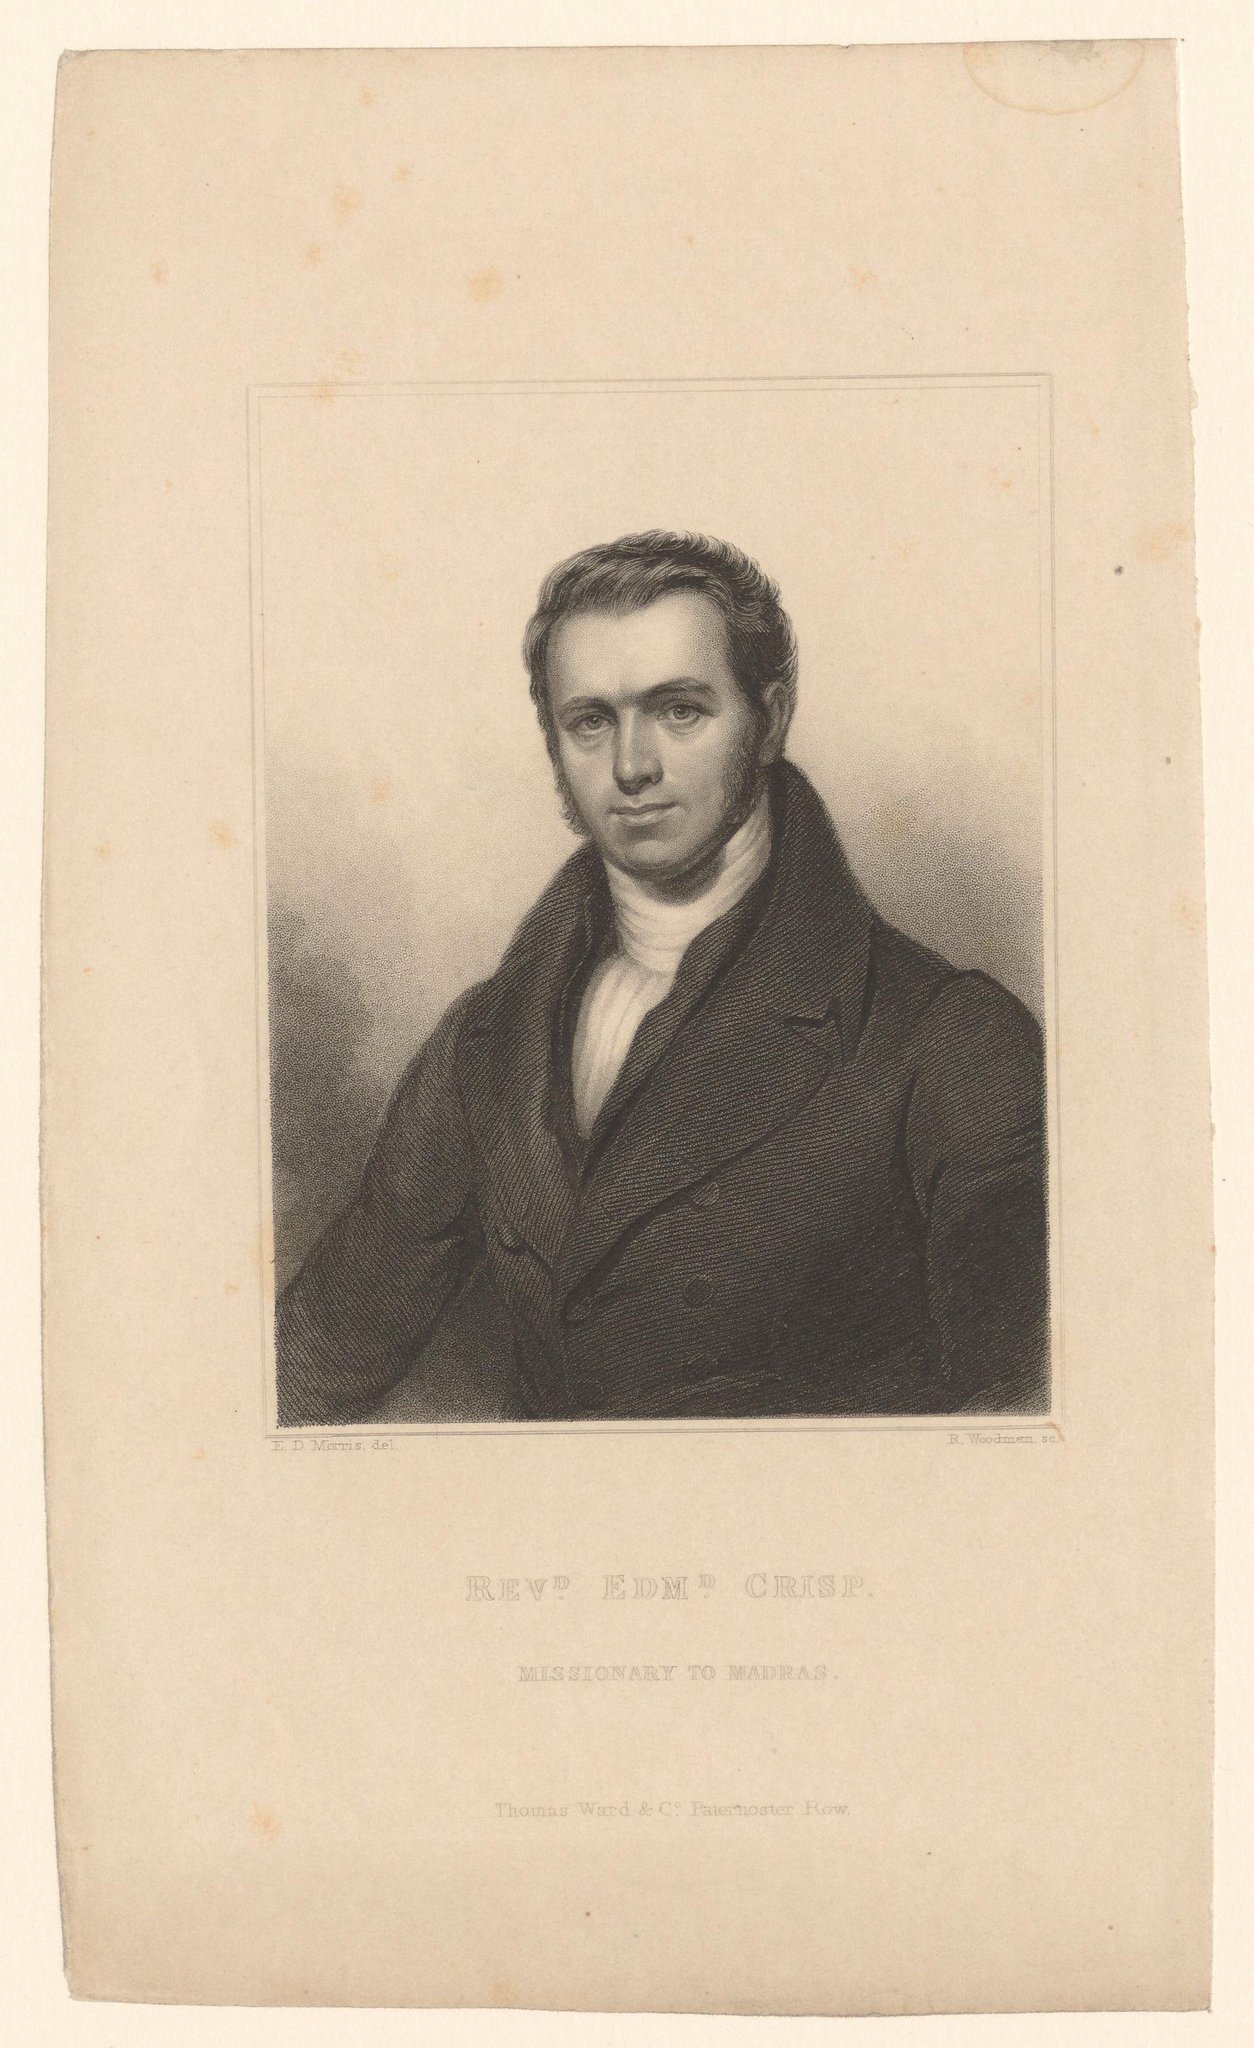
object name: print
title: Revd. Edmd. Crisp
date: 1820-1859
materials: paper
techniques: engraving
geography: london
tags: missionary, historical persons, spreading the gospel; missionary work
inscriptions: collector's mark: Lugt 2228